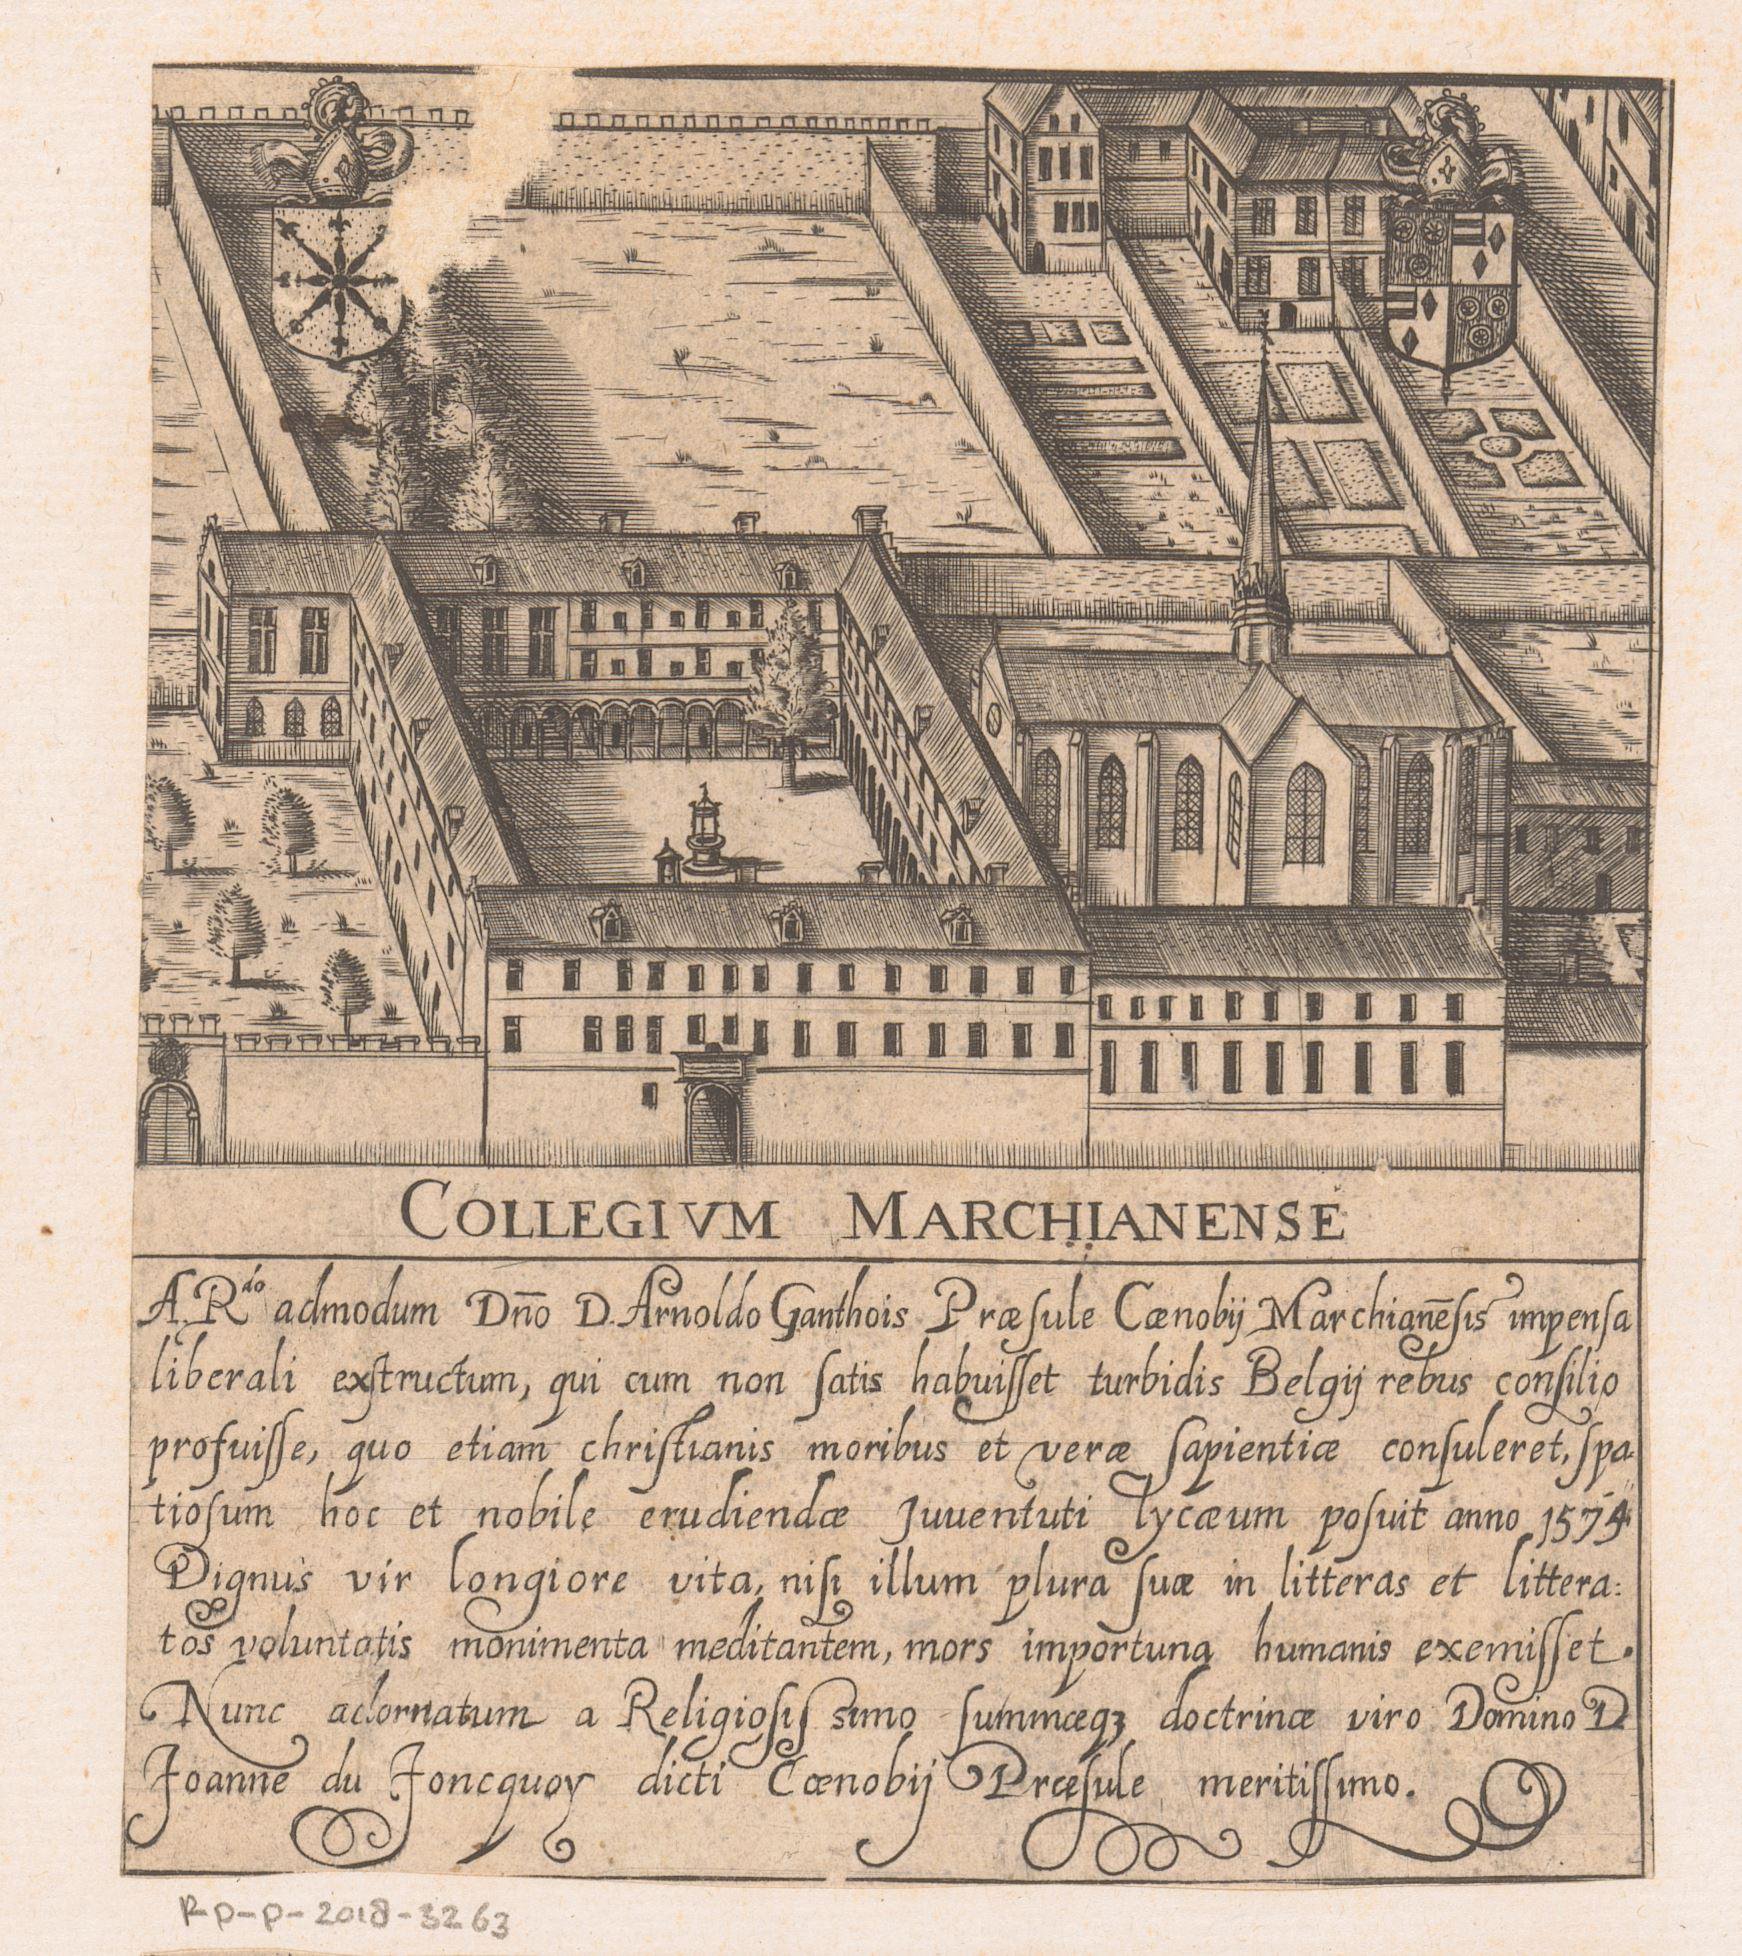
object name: book illustration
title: College van Marchianense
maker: filippo ferrari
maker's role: print maker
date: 1605-1680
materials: paper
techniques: etching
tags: university building, college, prospect of city, town panorama, silhouette of city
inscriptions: collector's mark: Lugt 2228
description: Onderdeel van een reeks gezichten op steden/gebouwen met bijbehorend voorblad met tekst en legenda. De legendanummers zijn naast de afbeeldingen bijgeschreven. De afbeeldingen zijn per zes op één blad bevestigd.